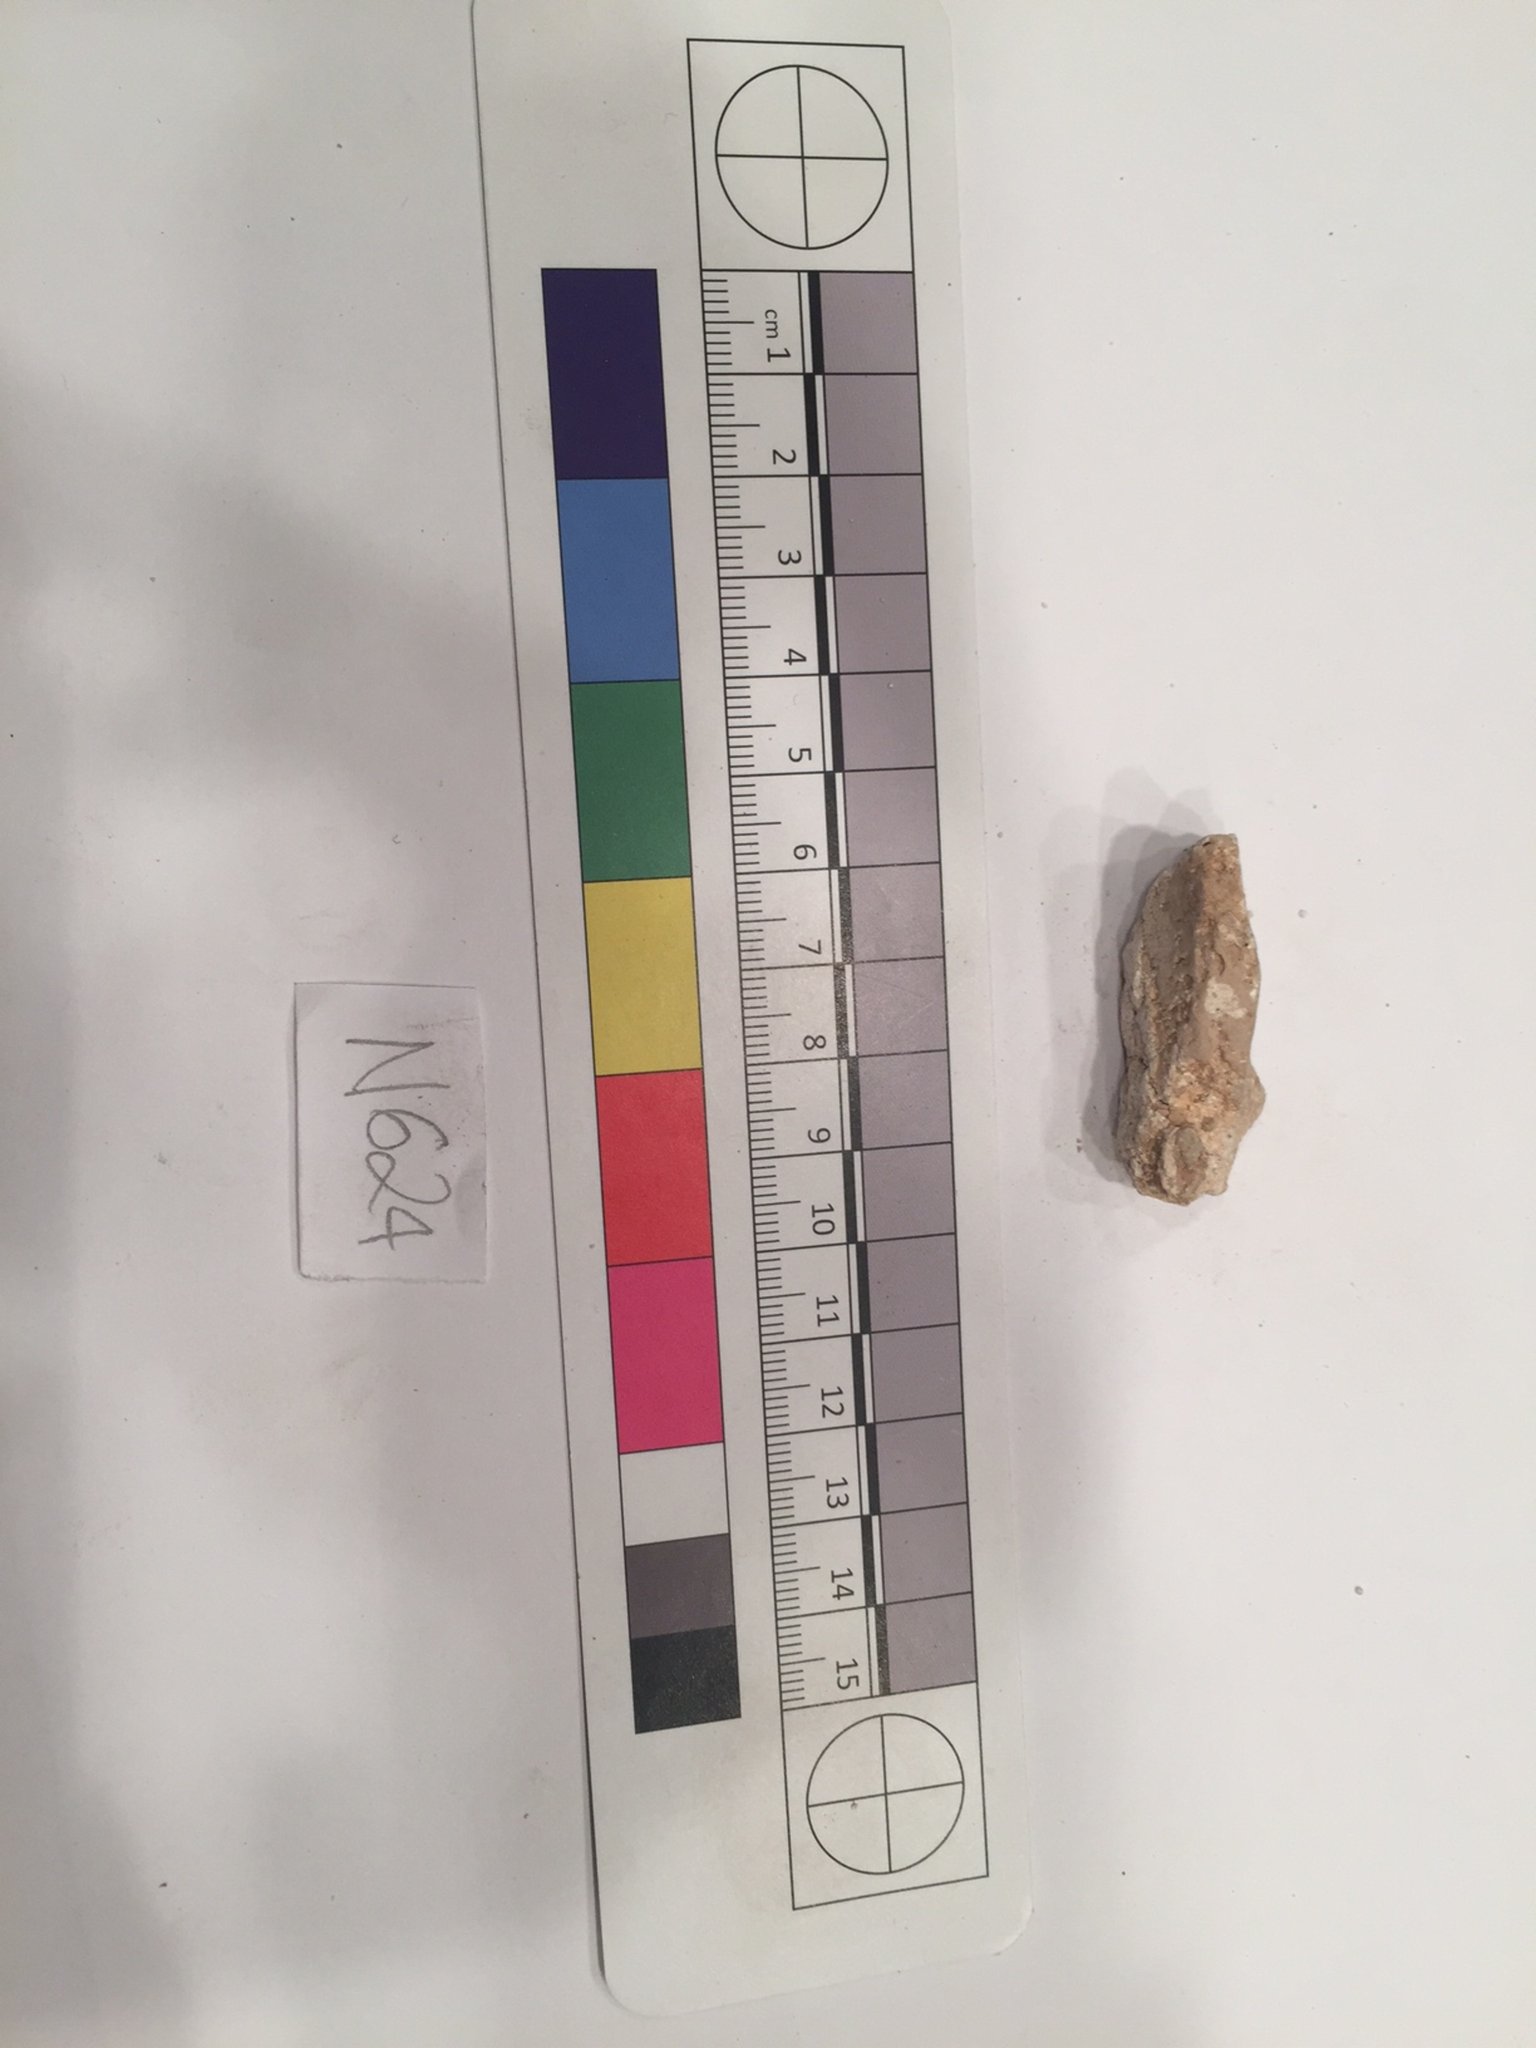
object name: fragment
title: Stucco Fragment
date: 701-1200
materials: plaster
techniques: carving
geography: iran